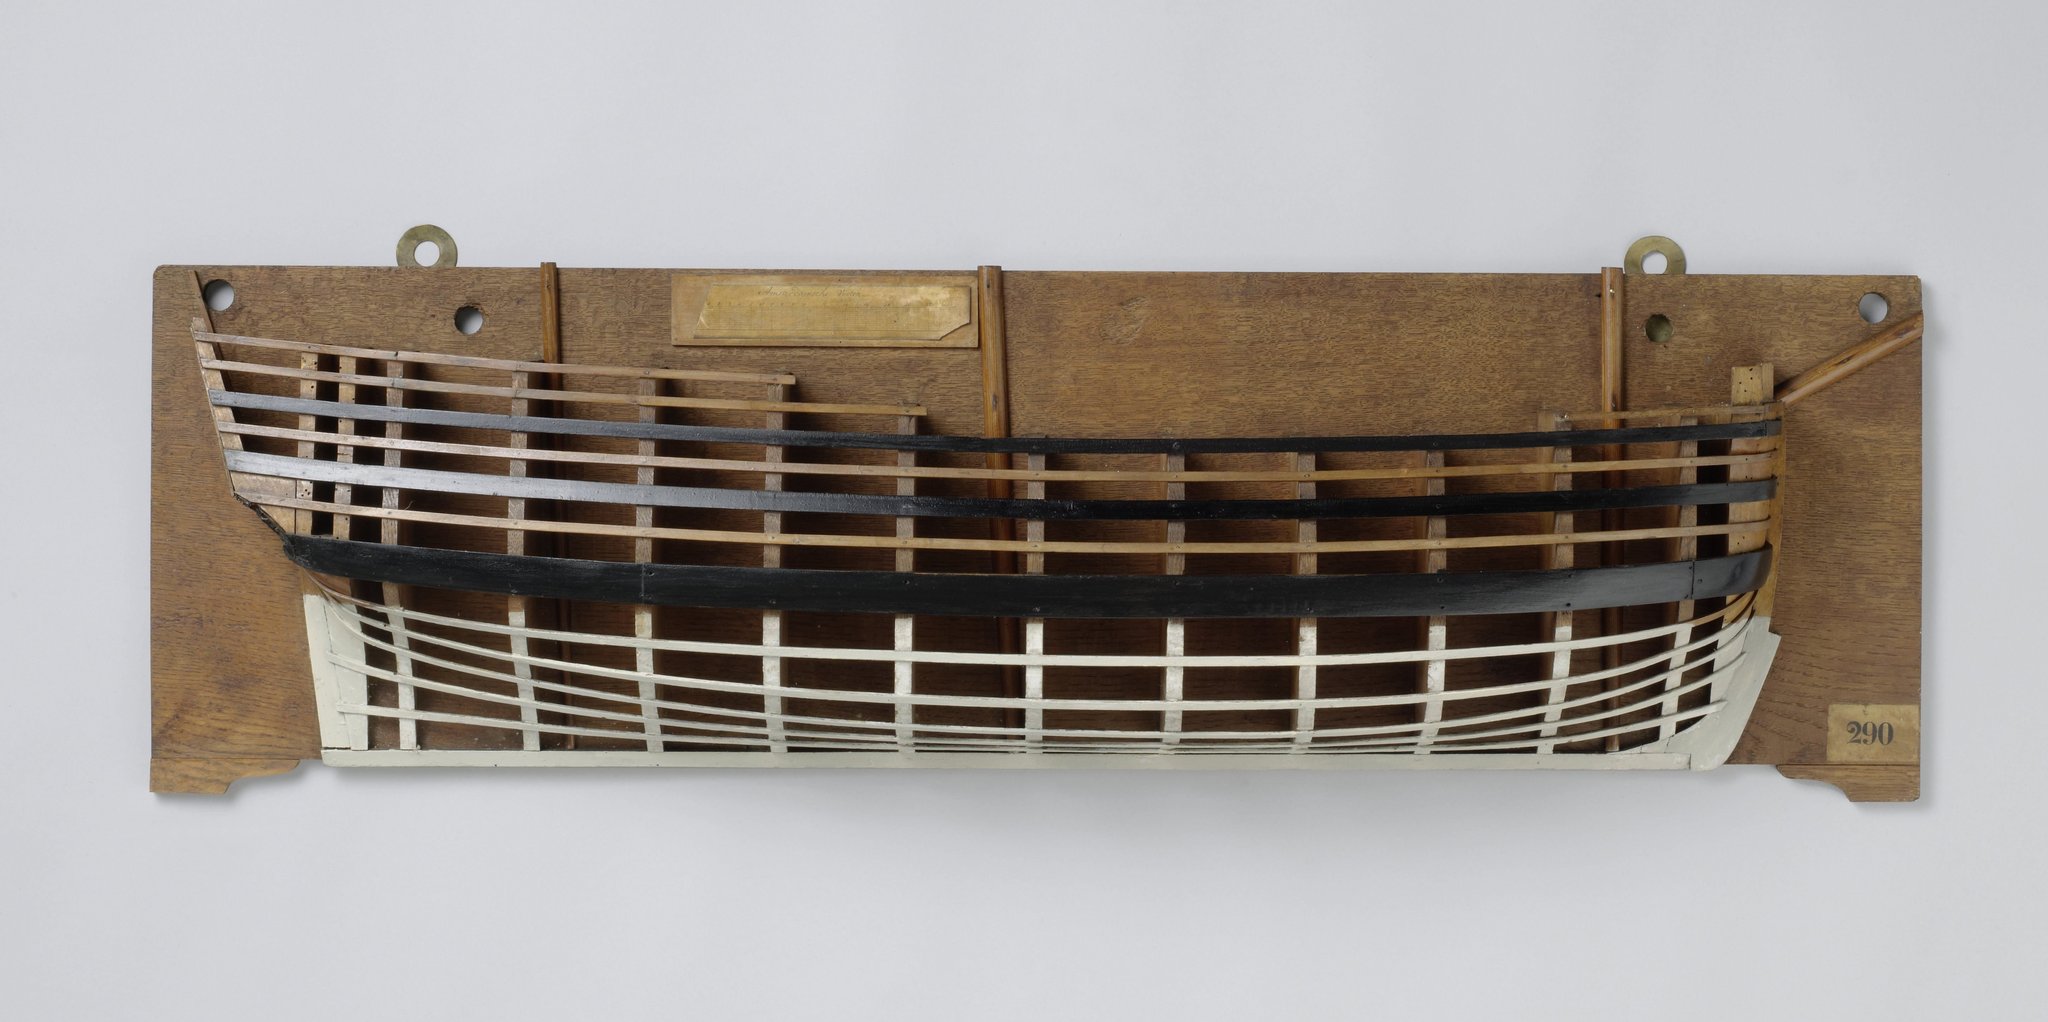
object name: builder's model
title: Half Model of a 36-Gun Frigate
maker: Anonymous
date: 1750-1800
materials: wood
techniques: polychromy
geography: netherlands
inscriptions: scale, top left: paper scale in Amsterdam feet, label, bottom right: ‘290’ former inventory label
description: Gepolychromeerd mallenmodel (stuurboord) van een driemaster. Géén geschutpoorten of dekken aangegeven, alleen het halfdek en de bak door middel van gillingen. Gewrongen spiegel, hol wulf; hek, zijgalerij en roer niet aangegeven. Zeeg aan beide uiteinden iets oplopend, twee berghouten en één reehout. Gepiekt rondspant. Schaal 1:48 (schaal op model).